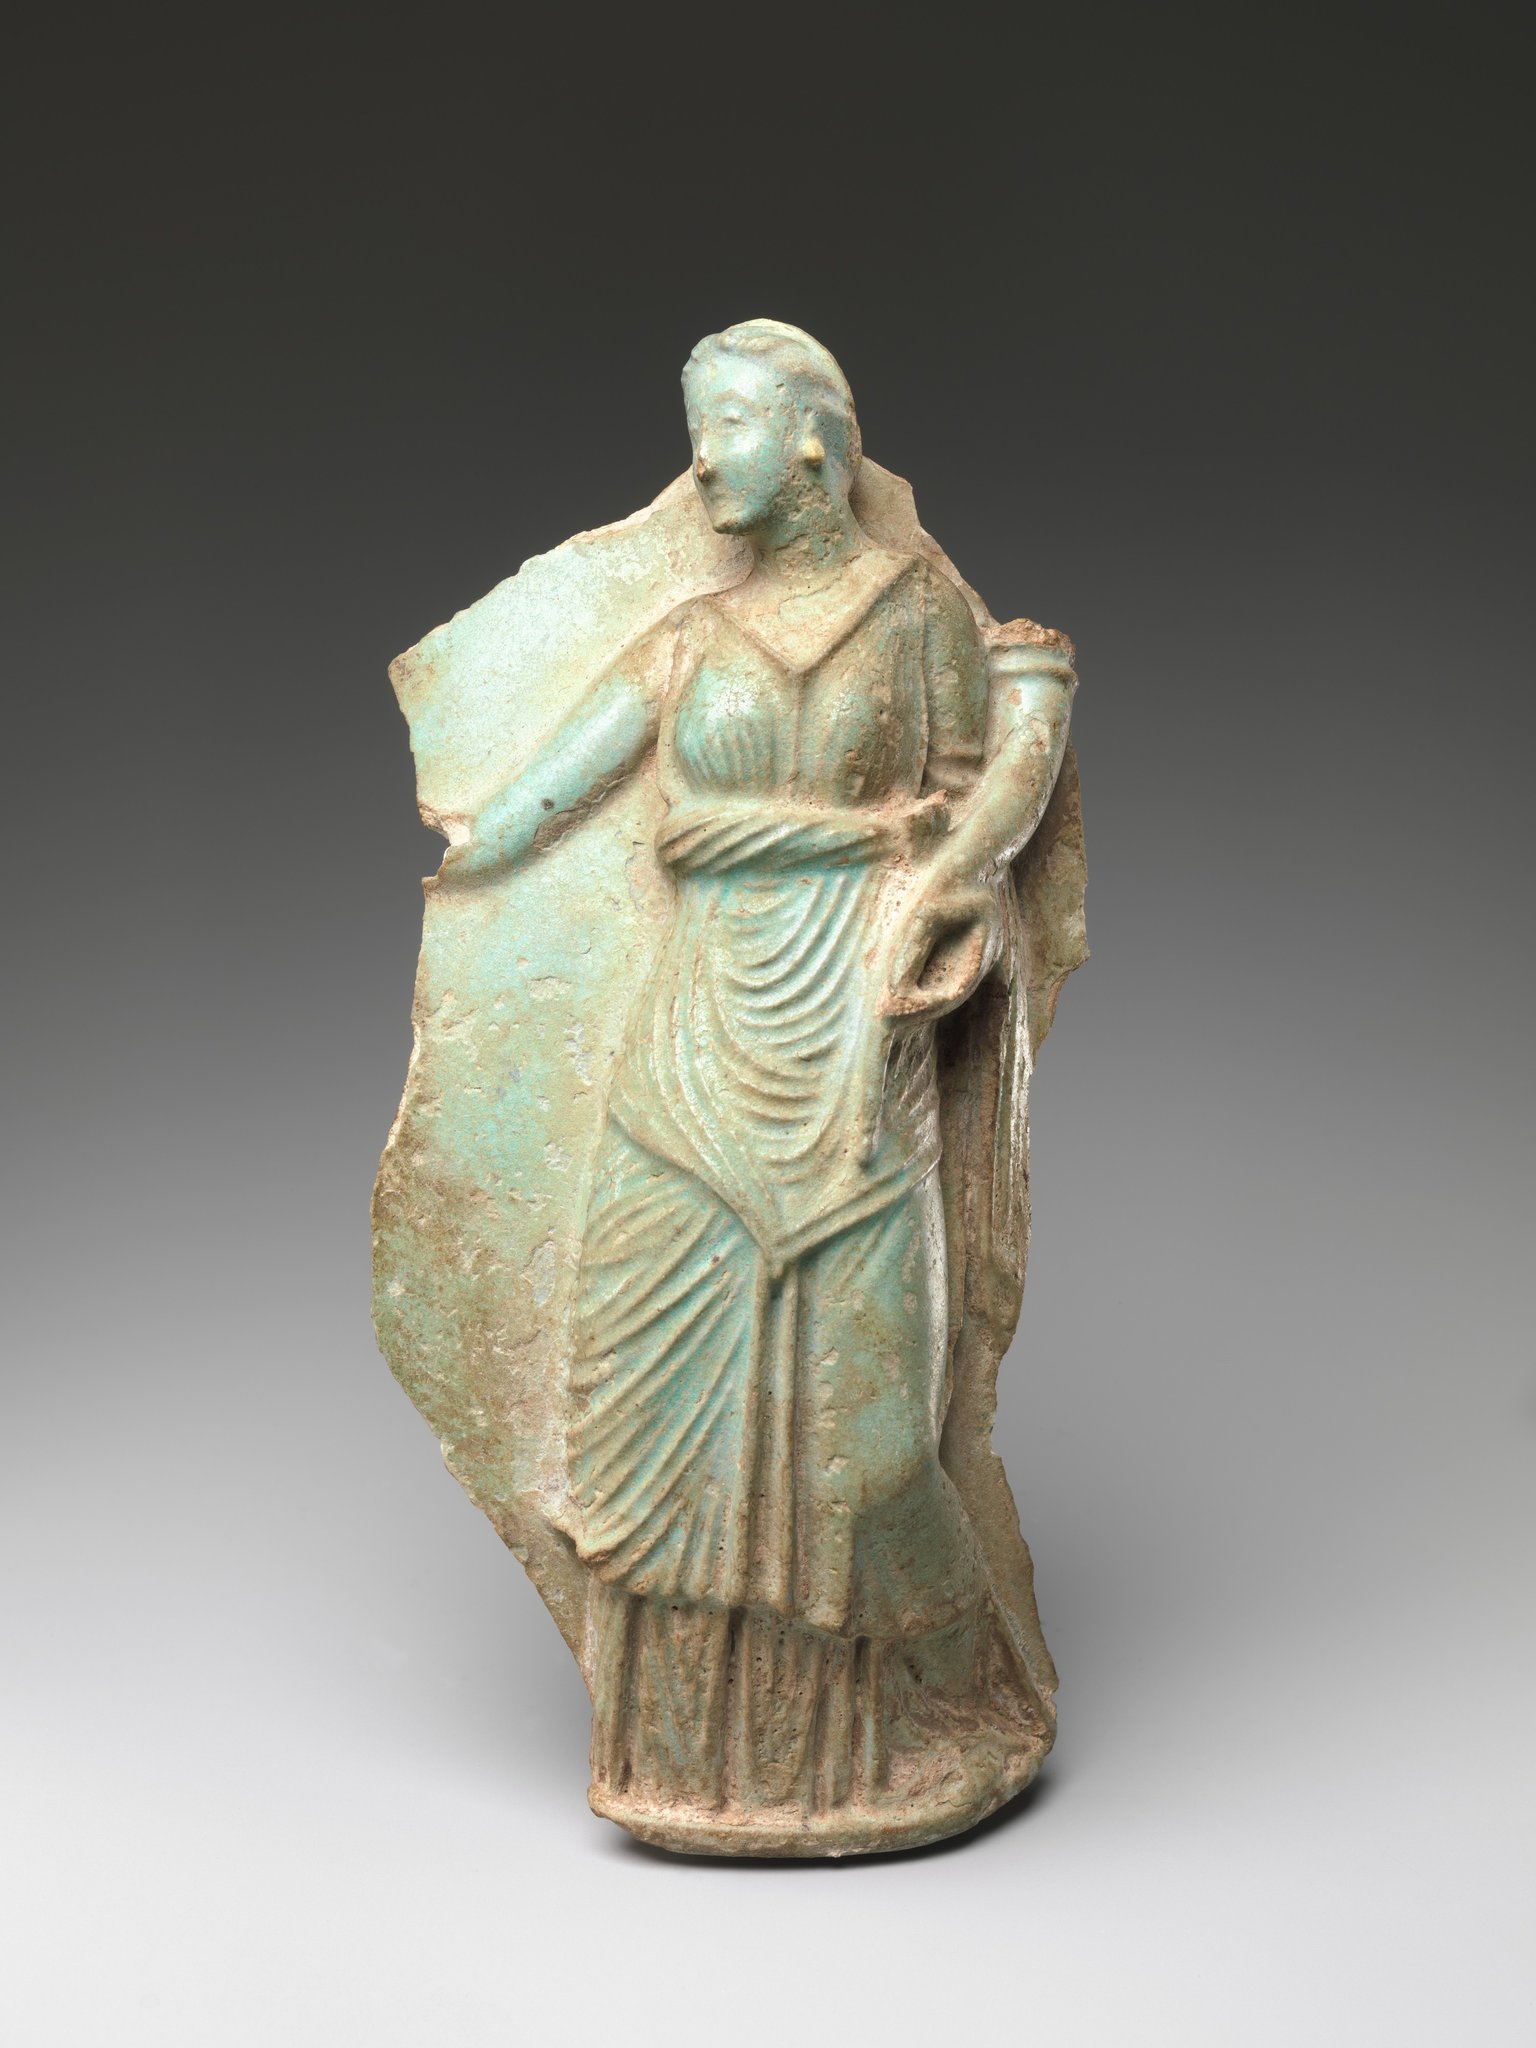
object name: vase fragment, berenike ii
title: Fragment of a Vase Depicting Berenike II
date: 246-221 BCE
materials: faience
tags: women